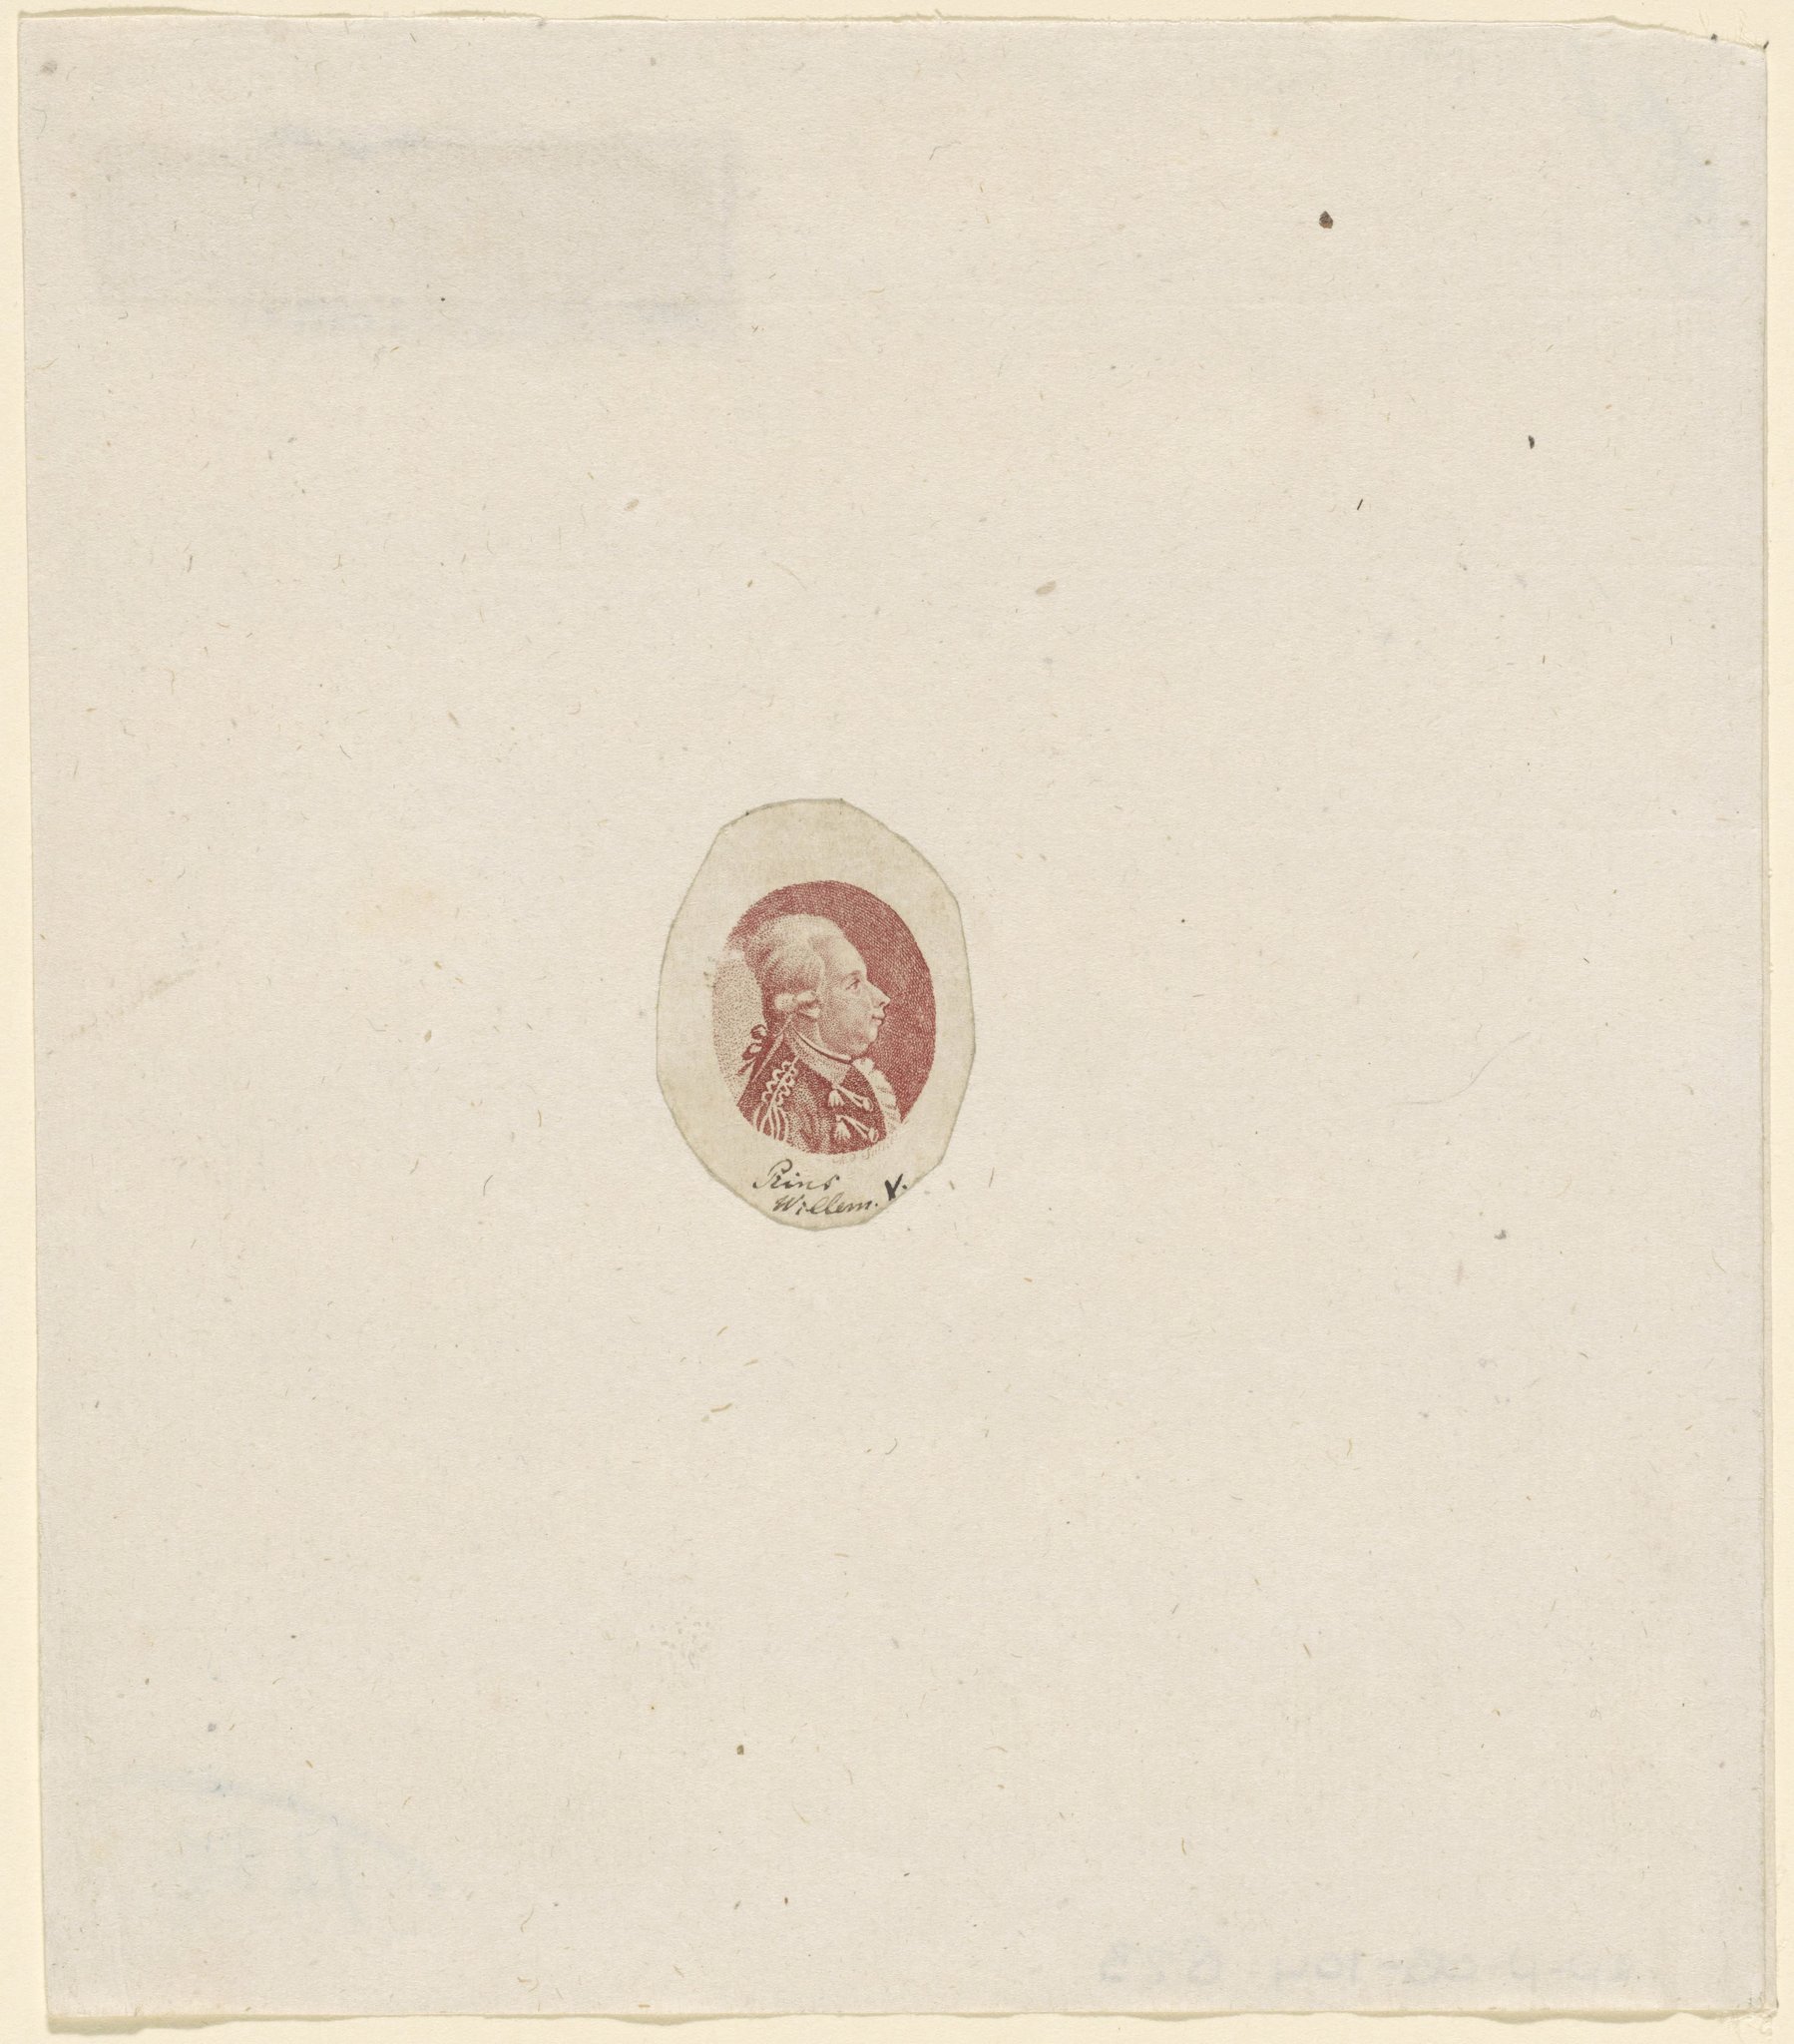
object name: print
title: Portret van Willem V, prins van Oranje-Nassau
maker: mathias de sallieth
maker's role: print maker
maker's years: 1749-1791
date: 1775-1791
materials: paper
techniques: engraving, etching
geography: northern netherlands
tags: the hague, william v (prince of orange)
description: De hier vermelde titel verwijst naar de hoogst verkregen titel van de geportretteerde, niet per se naar de titel die de geportretteerde op deze voorstelling draagt.